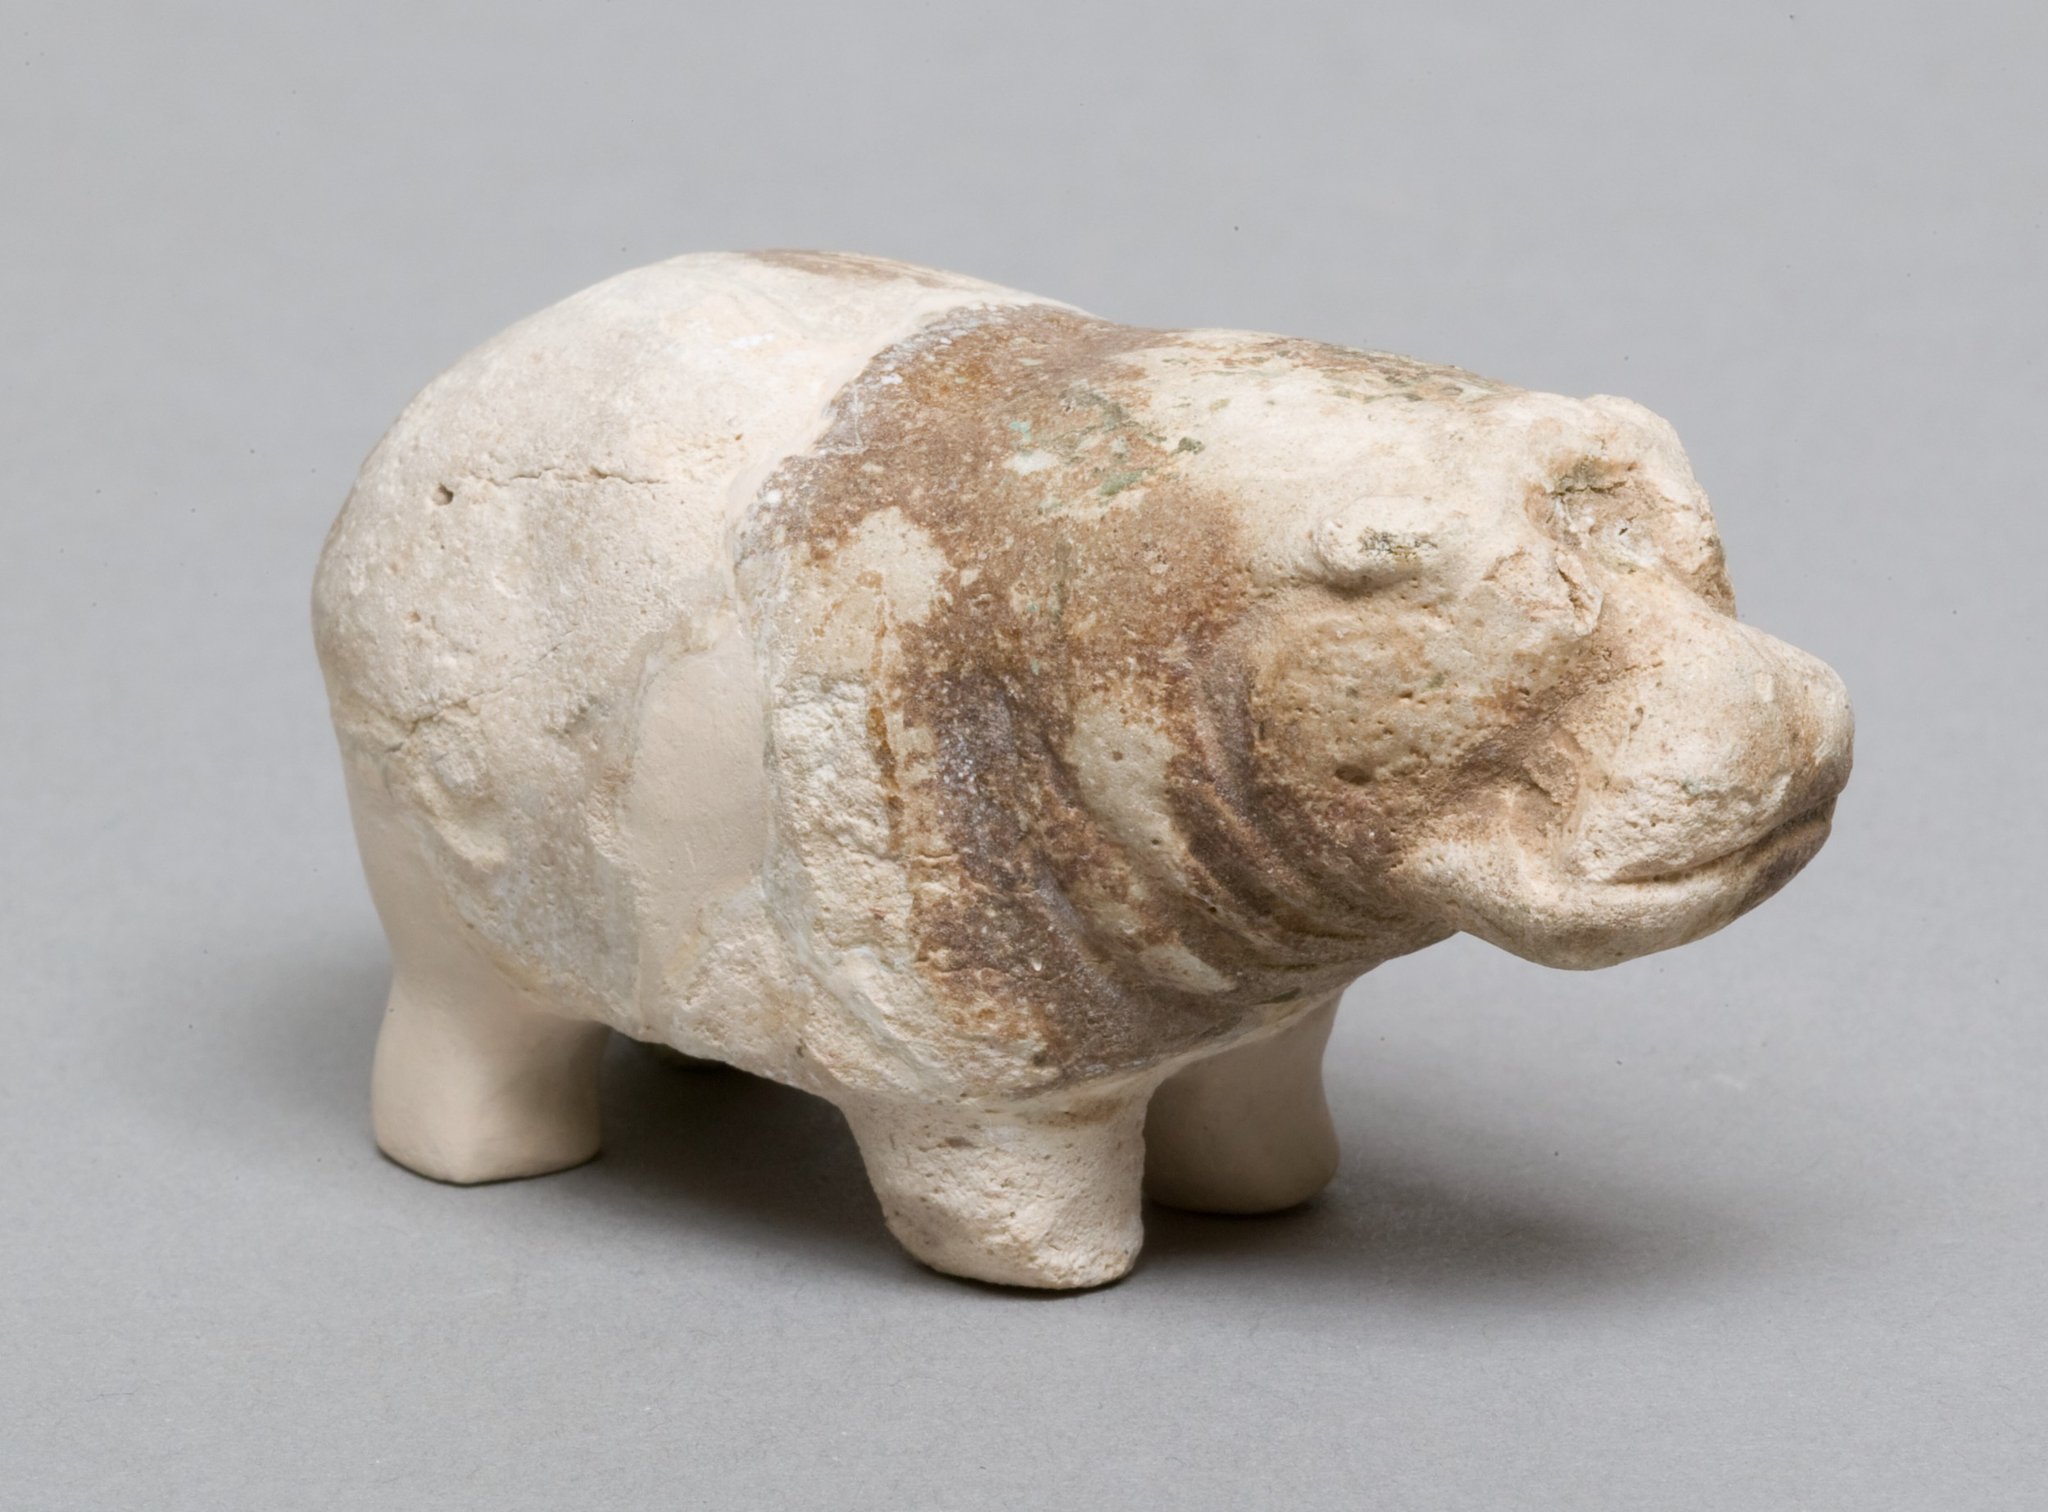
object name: figurine, hippopotamus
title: Hippopotamus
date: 1800-1600 BCE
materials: faience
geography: egypt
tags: hippos